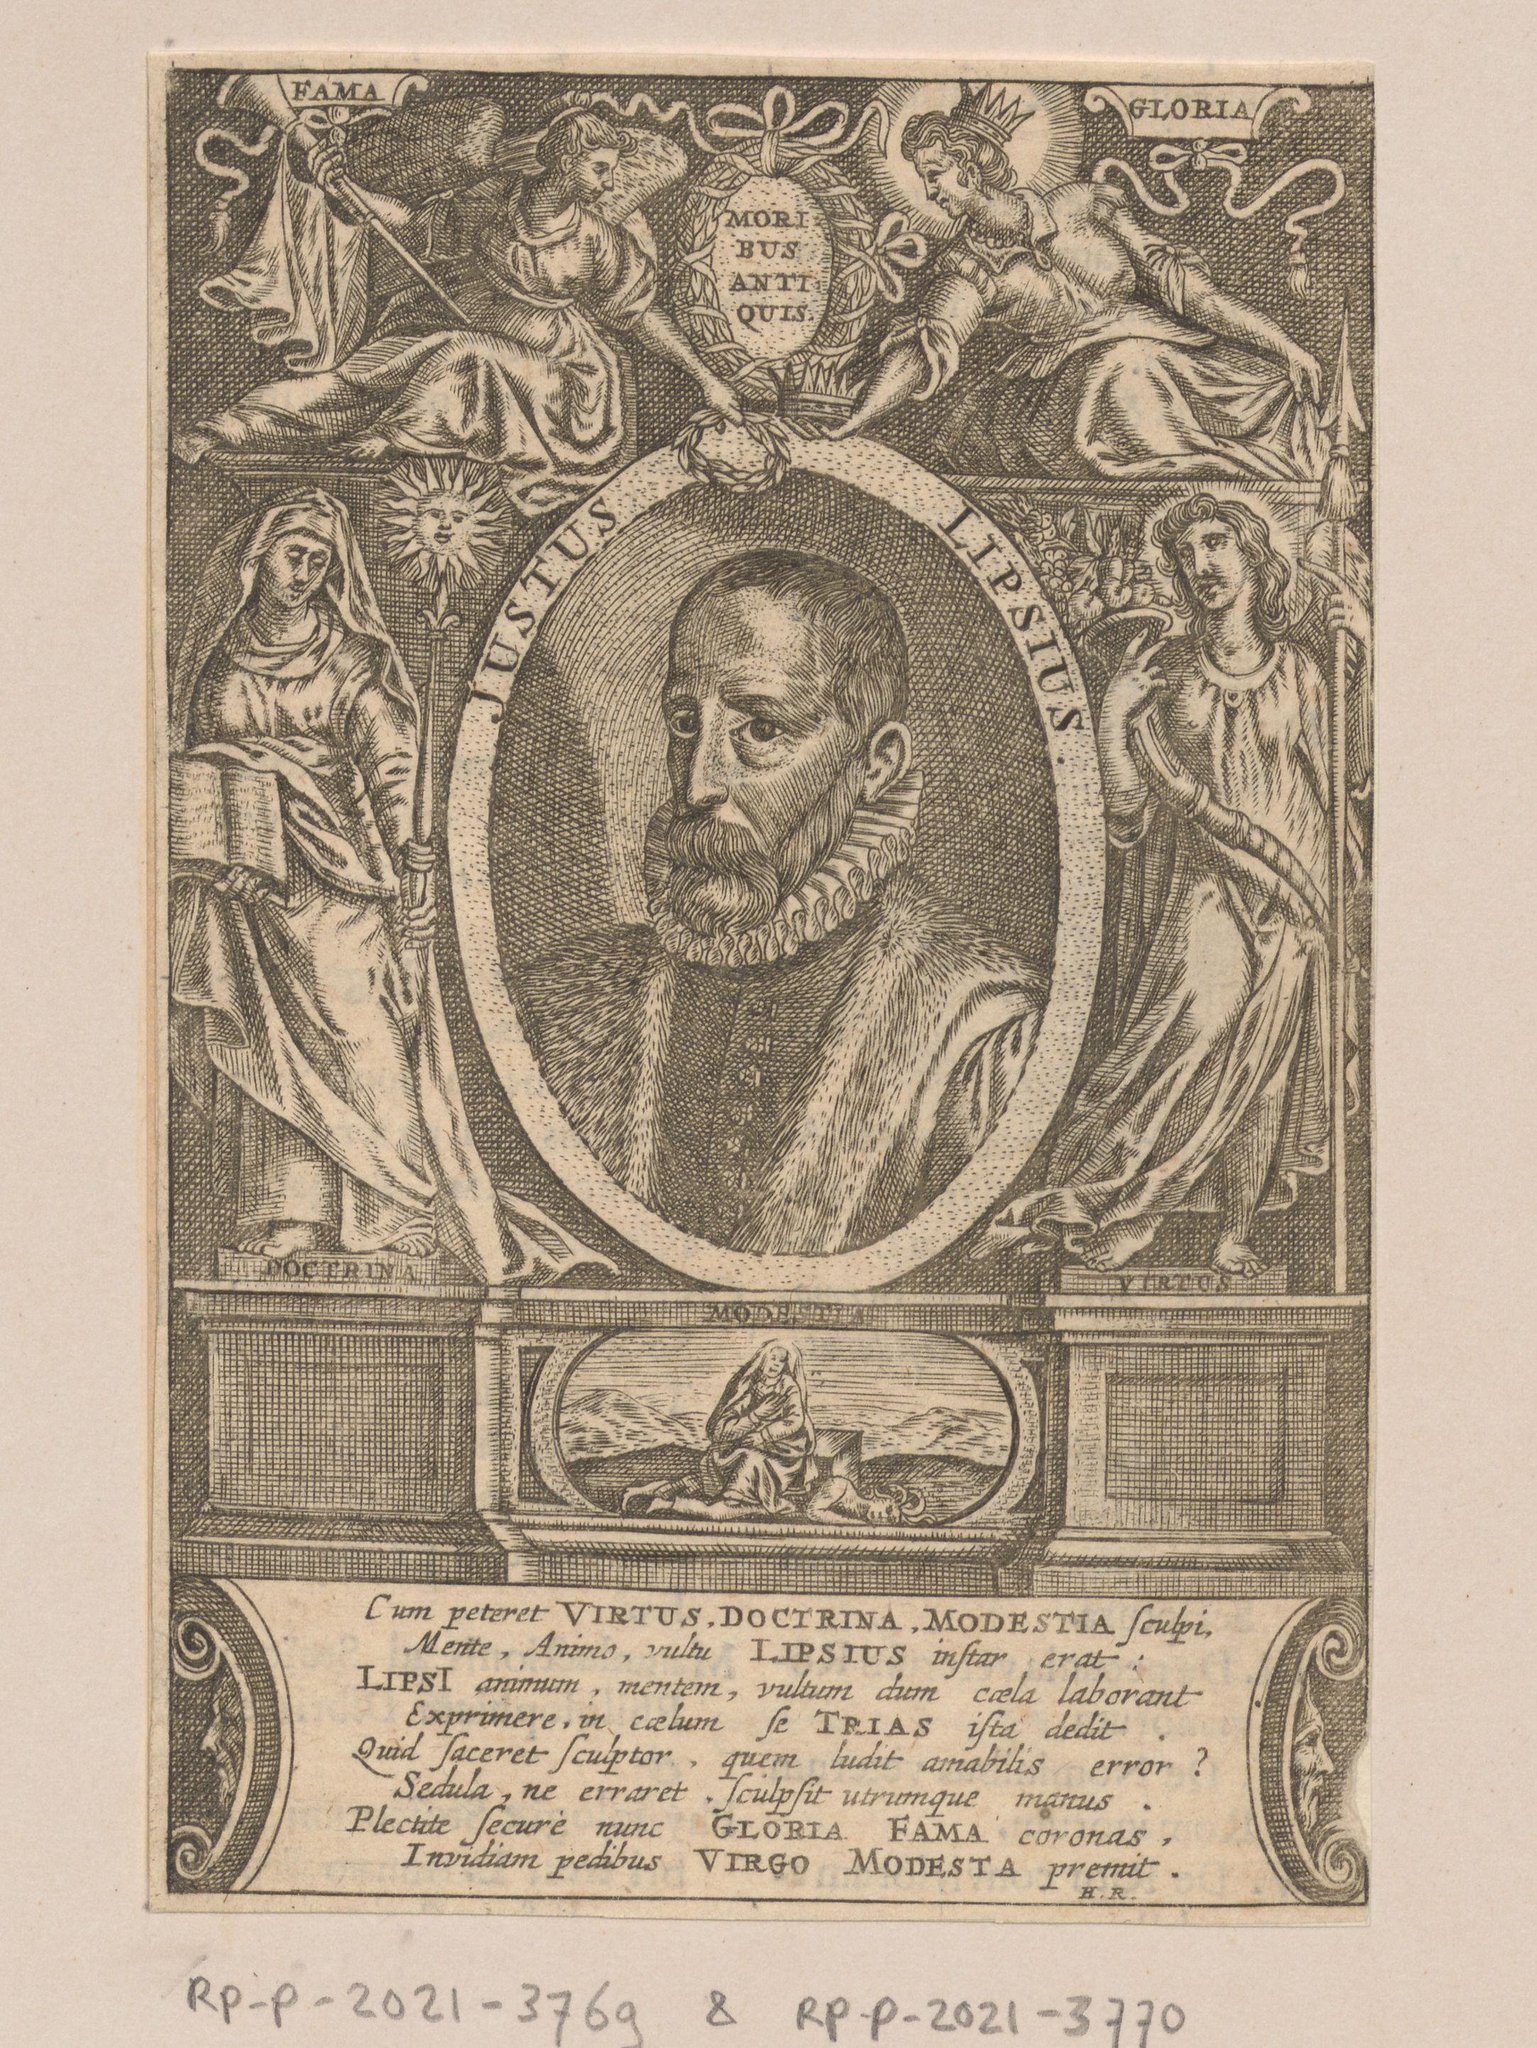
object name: print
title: Portret van Justus Lipsius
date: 1675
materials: paper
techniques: engraving, etching, letterpress printing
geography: wesel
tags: justus lipsius, envy; 'invidia' (ripa) ~ personification of one of the seven deadly sins, ornament ~ medallion, historical persons, portrait of a writer, virtuousness; 'amor di virtù', 'attione virtuosa', 'guida sicura de' veri honori', 'virtù', 'virtù insuperabile' (ripa), fame; 'fama', 'fama buona', 'fama chiara' (ripa), honour, glory; 'ampiezza della gloria', 'gloria', 'gloria de prencipi', 'gloria & honore', 'honore', 'sublimatà della gloria' (ripa), discretion, modesty; 'discretione', 'modestia' (ripa), doctrine (+ personification)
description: Portret in medaillon. Aan weerszijden van het portret de personificaties Leer (Doctrina) en Deugd (Virtus). Boven het portret de personificaties Roem (Fama) en Heerlijkheid (Gloria). Onder het portret de personificatie Bescheidenheid (Modesta), die Nijd (Invidia) vertrapt. Met achtregelig vers in het Latijn onder het portret.